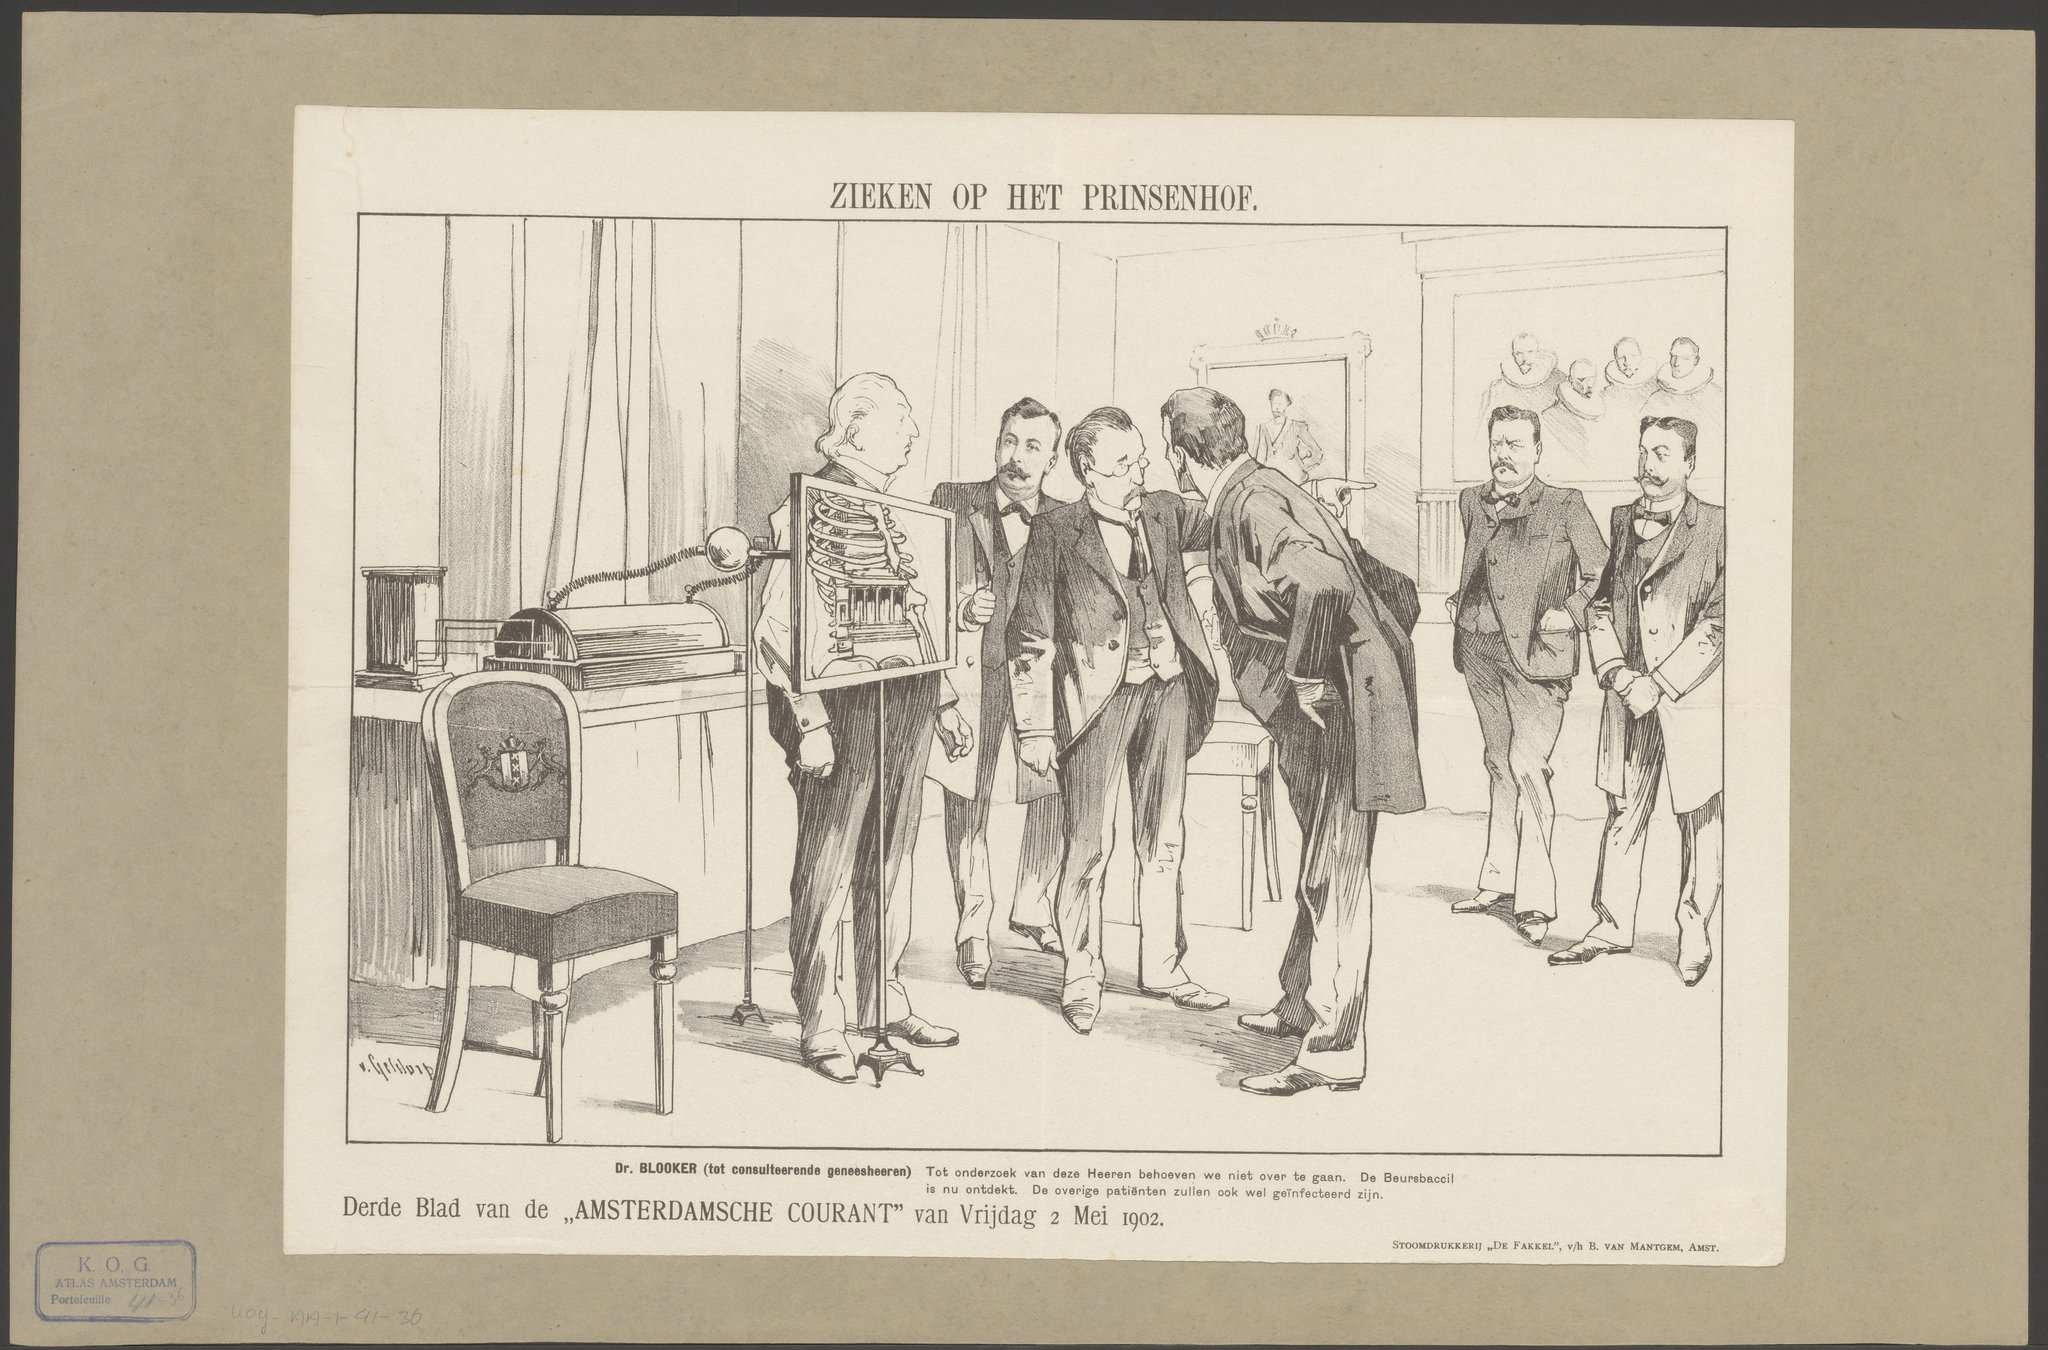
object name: print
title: Dokter bekijkt een ribbenkast met een röntgenapparaat, hier ziet hij de beurs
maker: jan geldorp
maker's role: draughtsman, painter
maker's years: 1810-1884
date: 1902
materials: paper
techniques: letterpress printing, lithograph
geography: amsterdam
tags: amsterdam, utrecht, city council, stock exchange, stock-market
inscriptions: collector's mark: Lugt 1461b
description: Dokter bekijkt een ribbenkast met een röntgenapparaat, hier ziet hij de beurs. Hij concludeert dat al zijn patiënten hiermee besmet zijn. Onderwerpsrubriek binnen de Atlas Amsterdam: B. Beurs op het Damrak.